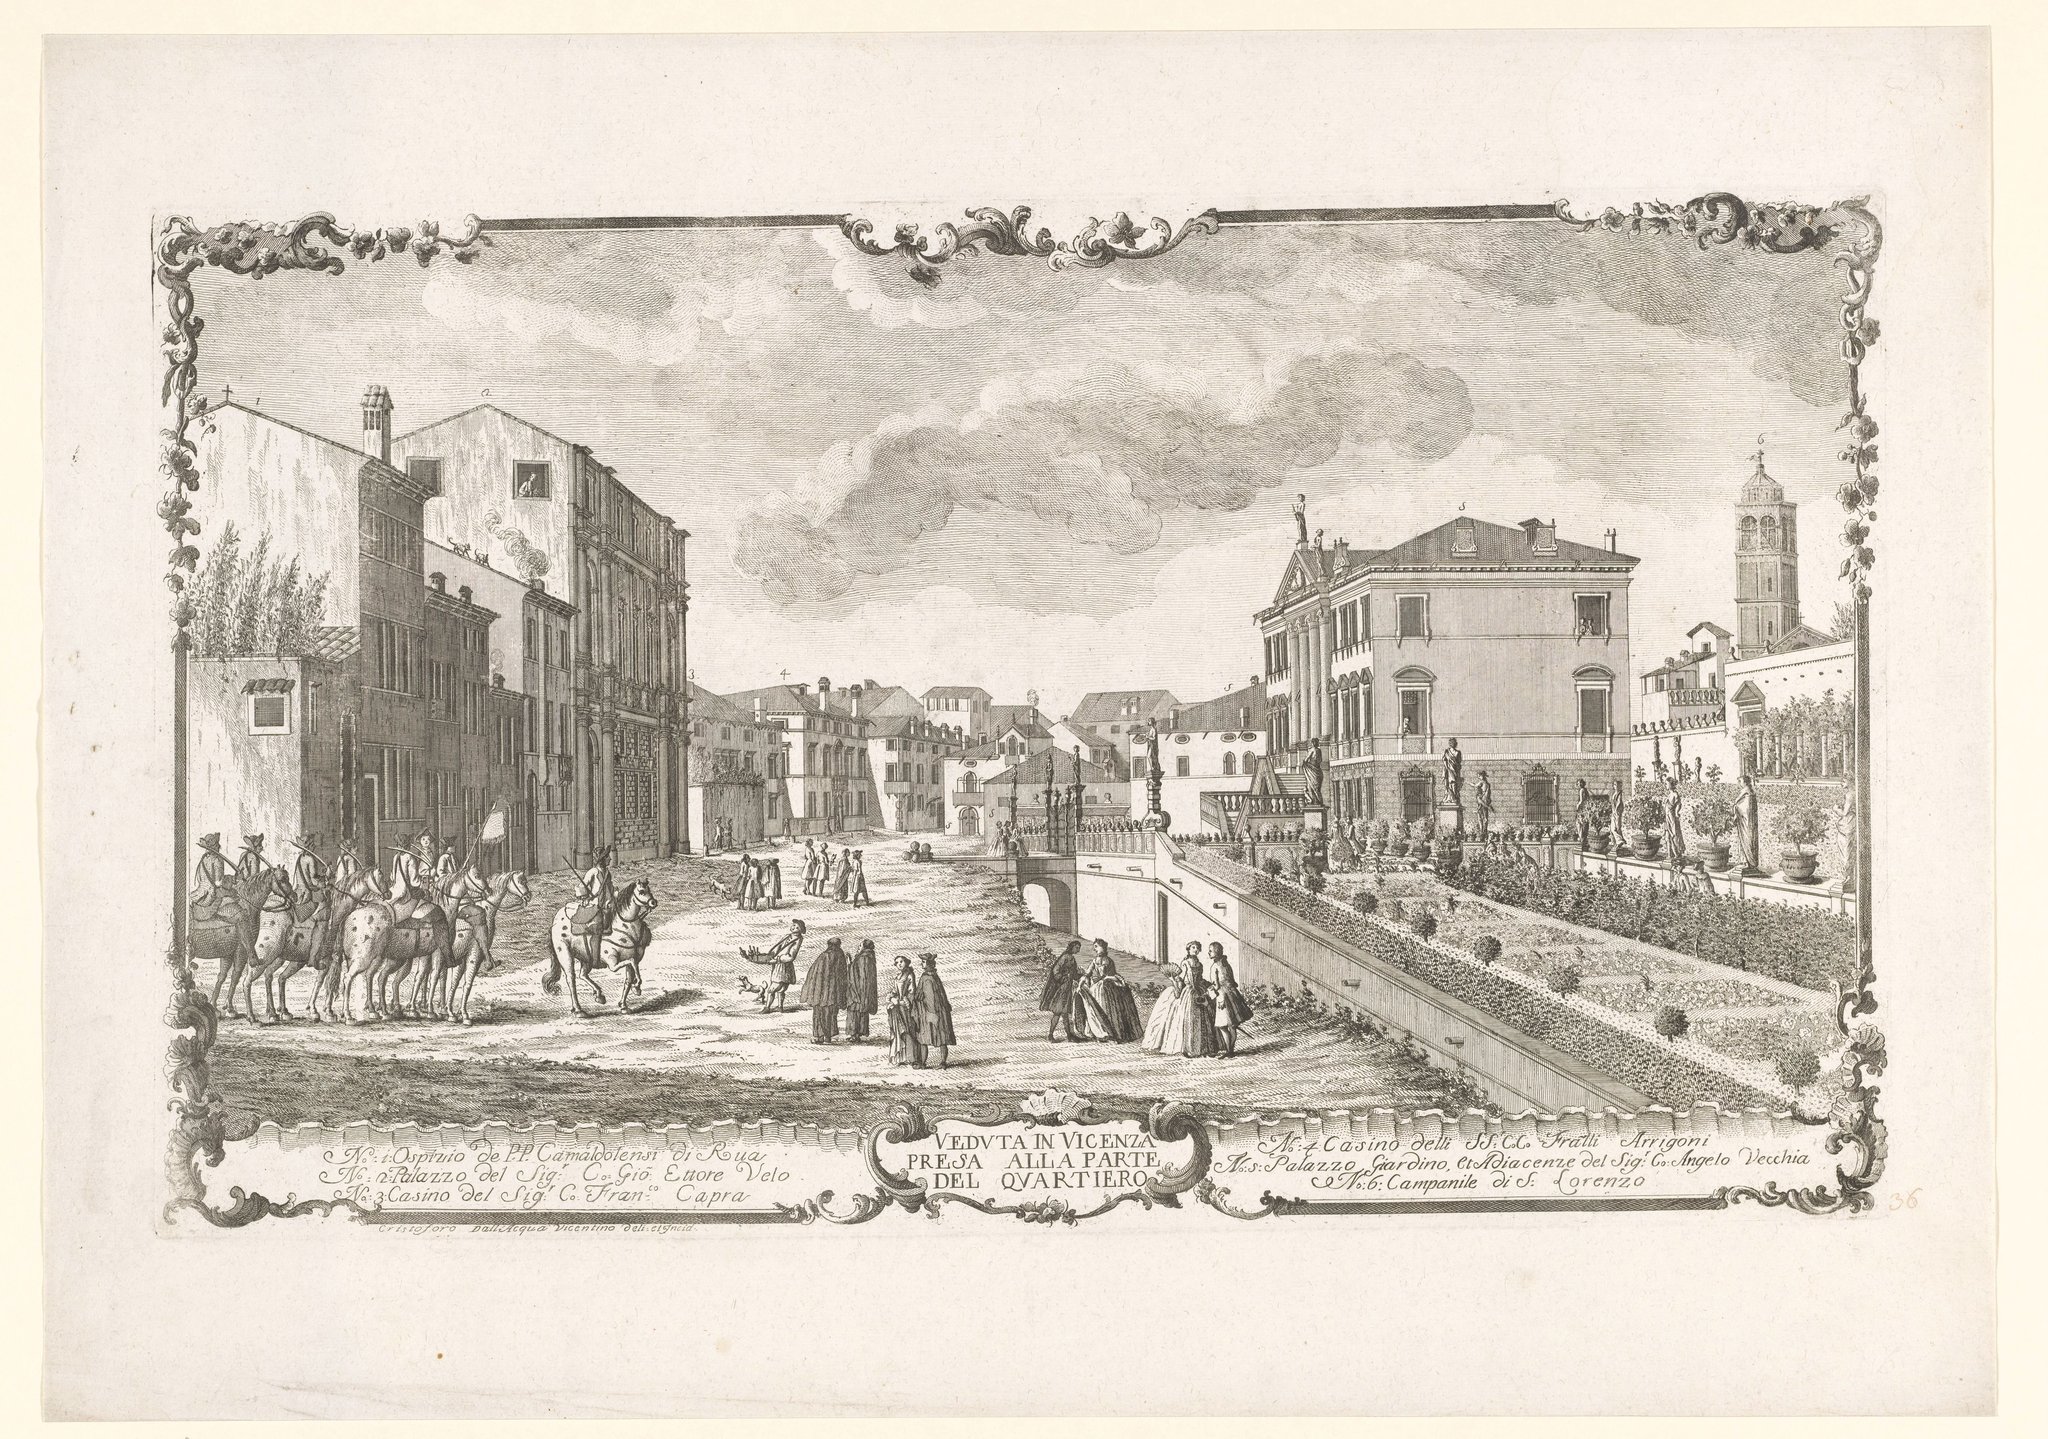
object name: print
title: Veduta in Vicenza presa alla parte del Quartiero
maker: cristoforo dall acqua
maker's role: draughtsman, print maker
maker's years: 1734-1787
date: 1744-1787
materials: paper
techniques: etching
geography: italy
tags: city-view, and landscape with man-made constructions, garden, warfare; military affairs (+ cavalry, horsemen), hôtel, i.e. small palace in city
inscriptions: collector's mark: Lugt 2228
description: Gezicht op verschillende gebouwen en het palazzo en de tuin van Angelo Vecchia in de Quartiero wijk in Vicenza. Op de voorgrond links een groep soldaten te paard. Verklarende lijst met nummers en titel in cartouche in ondermarge.